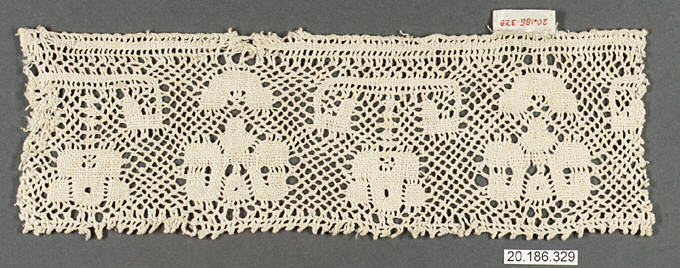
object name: edging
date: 1501-1600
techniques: lace